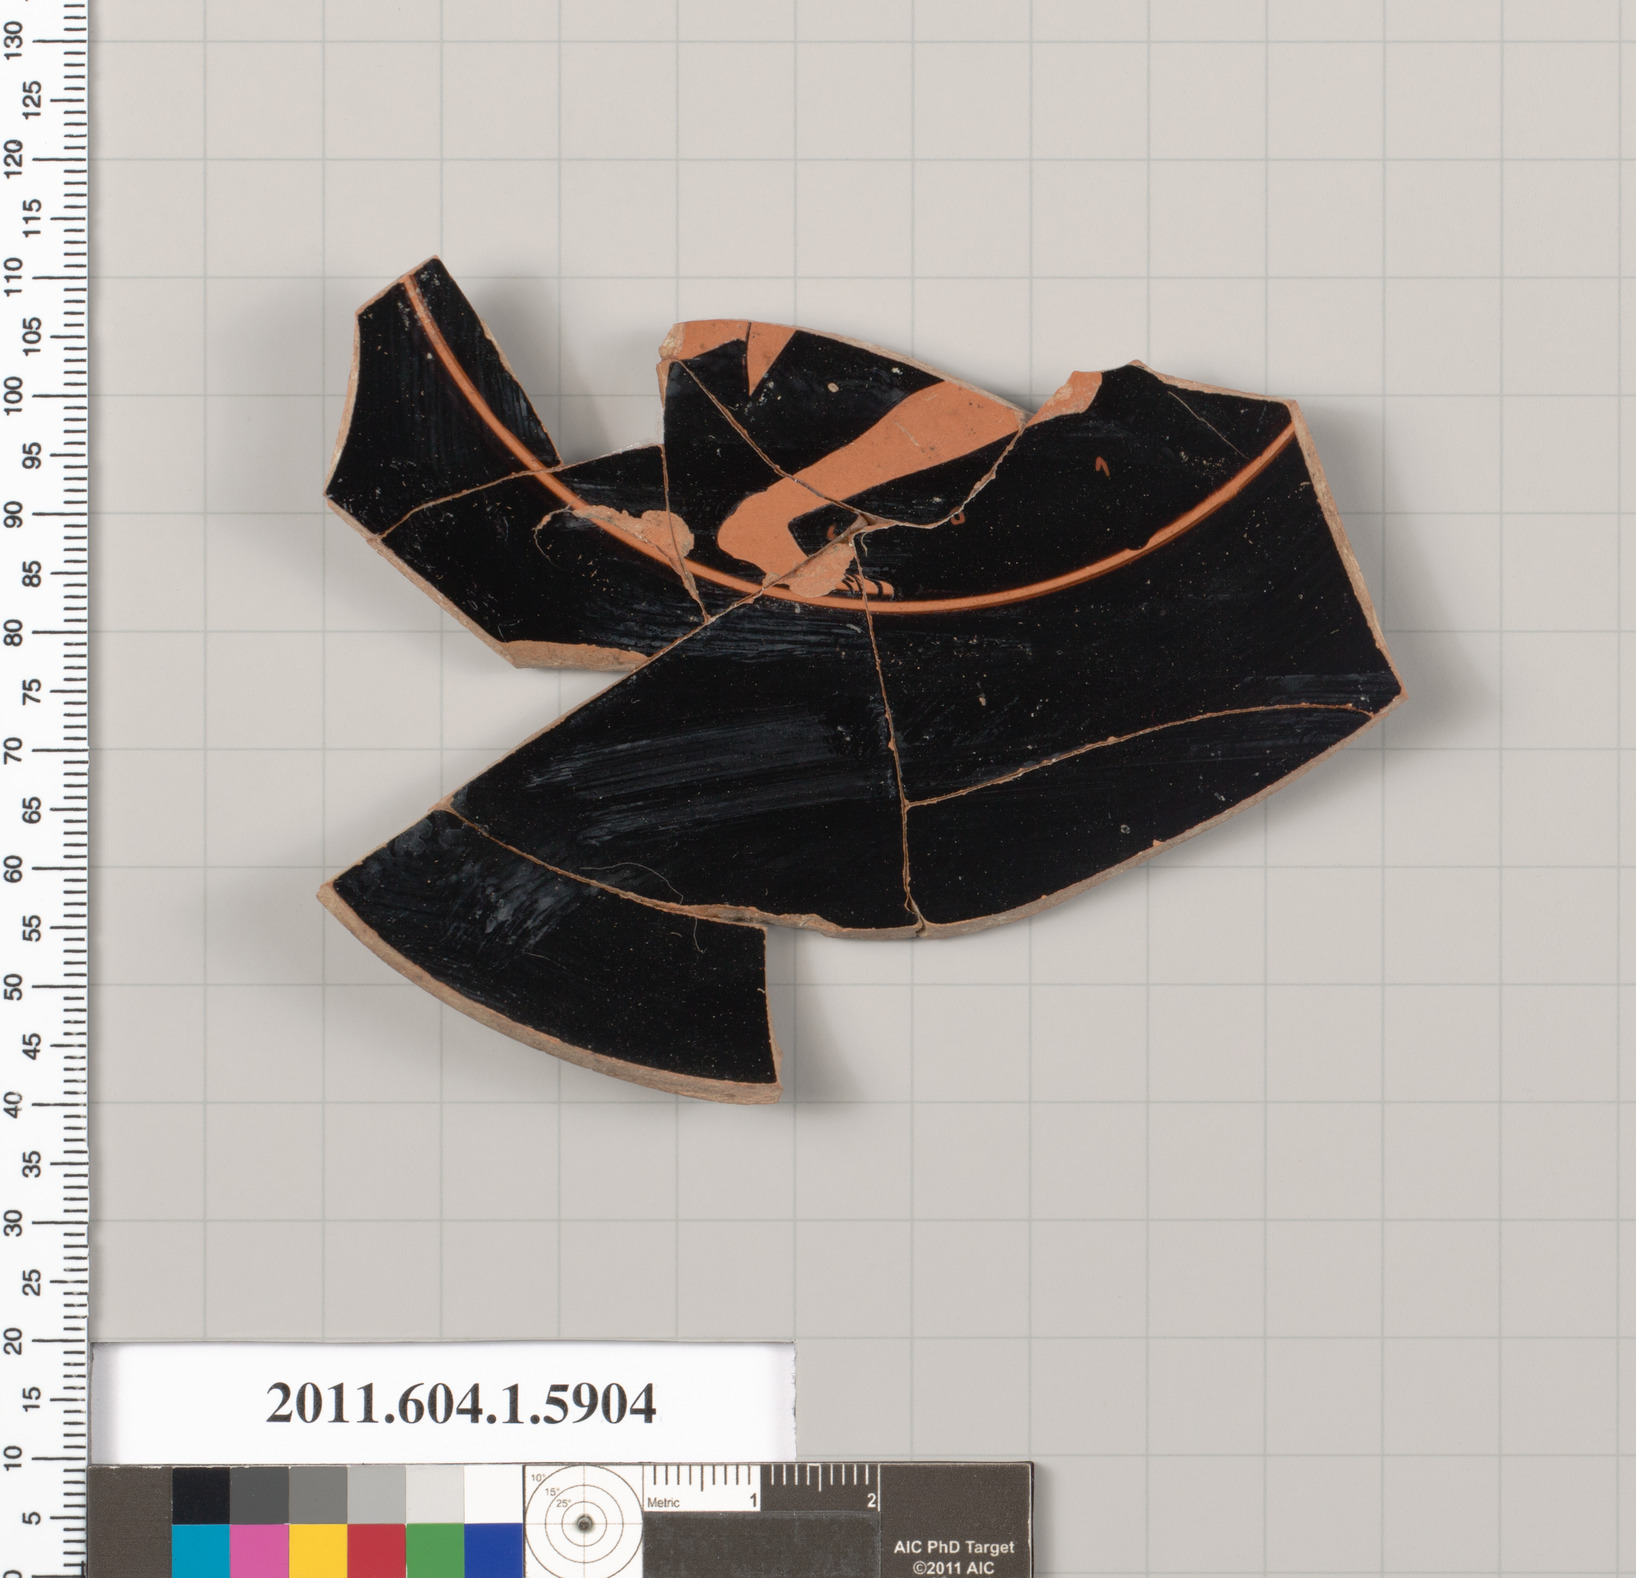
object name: kylix fragment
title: Terracotta fragment of a kylix (drinking cup)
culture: greek, attic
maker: epiktetos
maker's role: artist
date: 520-510 BCE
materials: terracotta